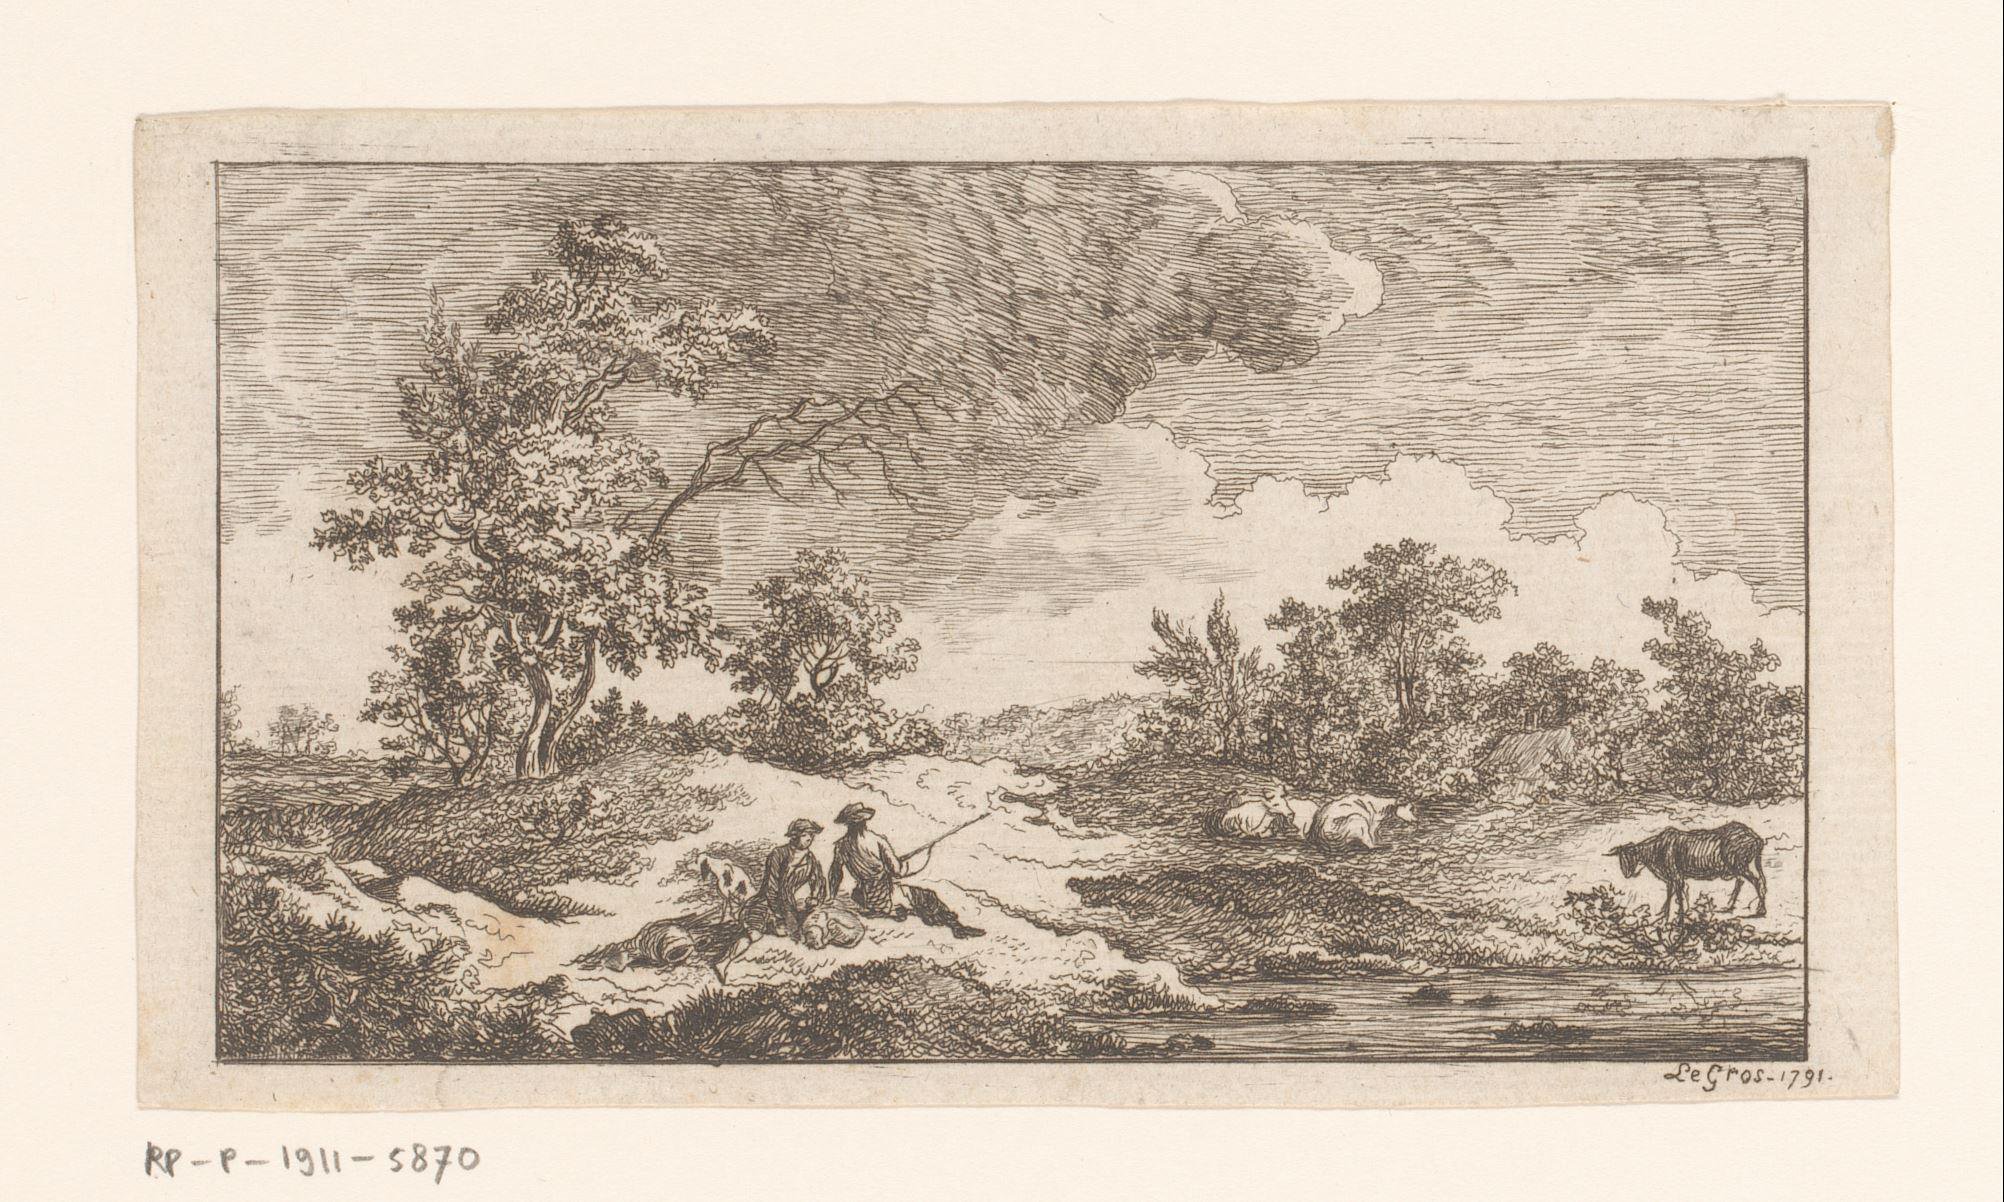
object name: print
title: Landschap met rustende jagers en koeien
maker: sauveur legros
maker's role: print maker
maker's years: 1754-1834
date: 1791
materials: paper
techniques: etching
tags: hunter, landscapes (+ landscape with figures, staffage)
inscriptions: collector's mark: Lugt 2228